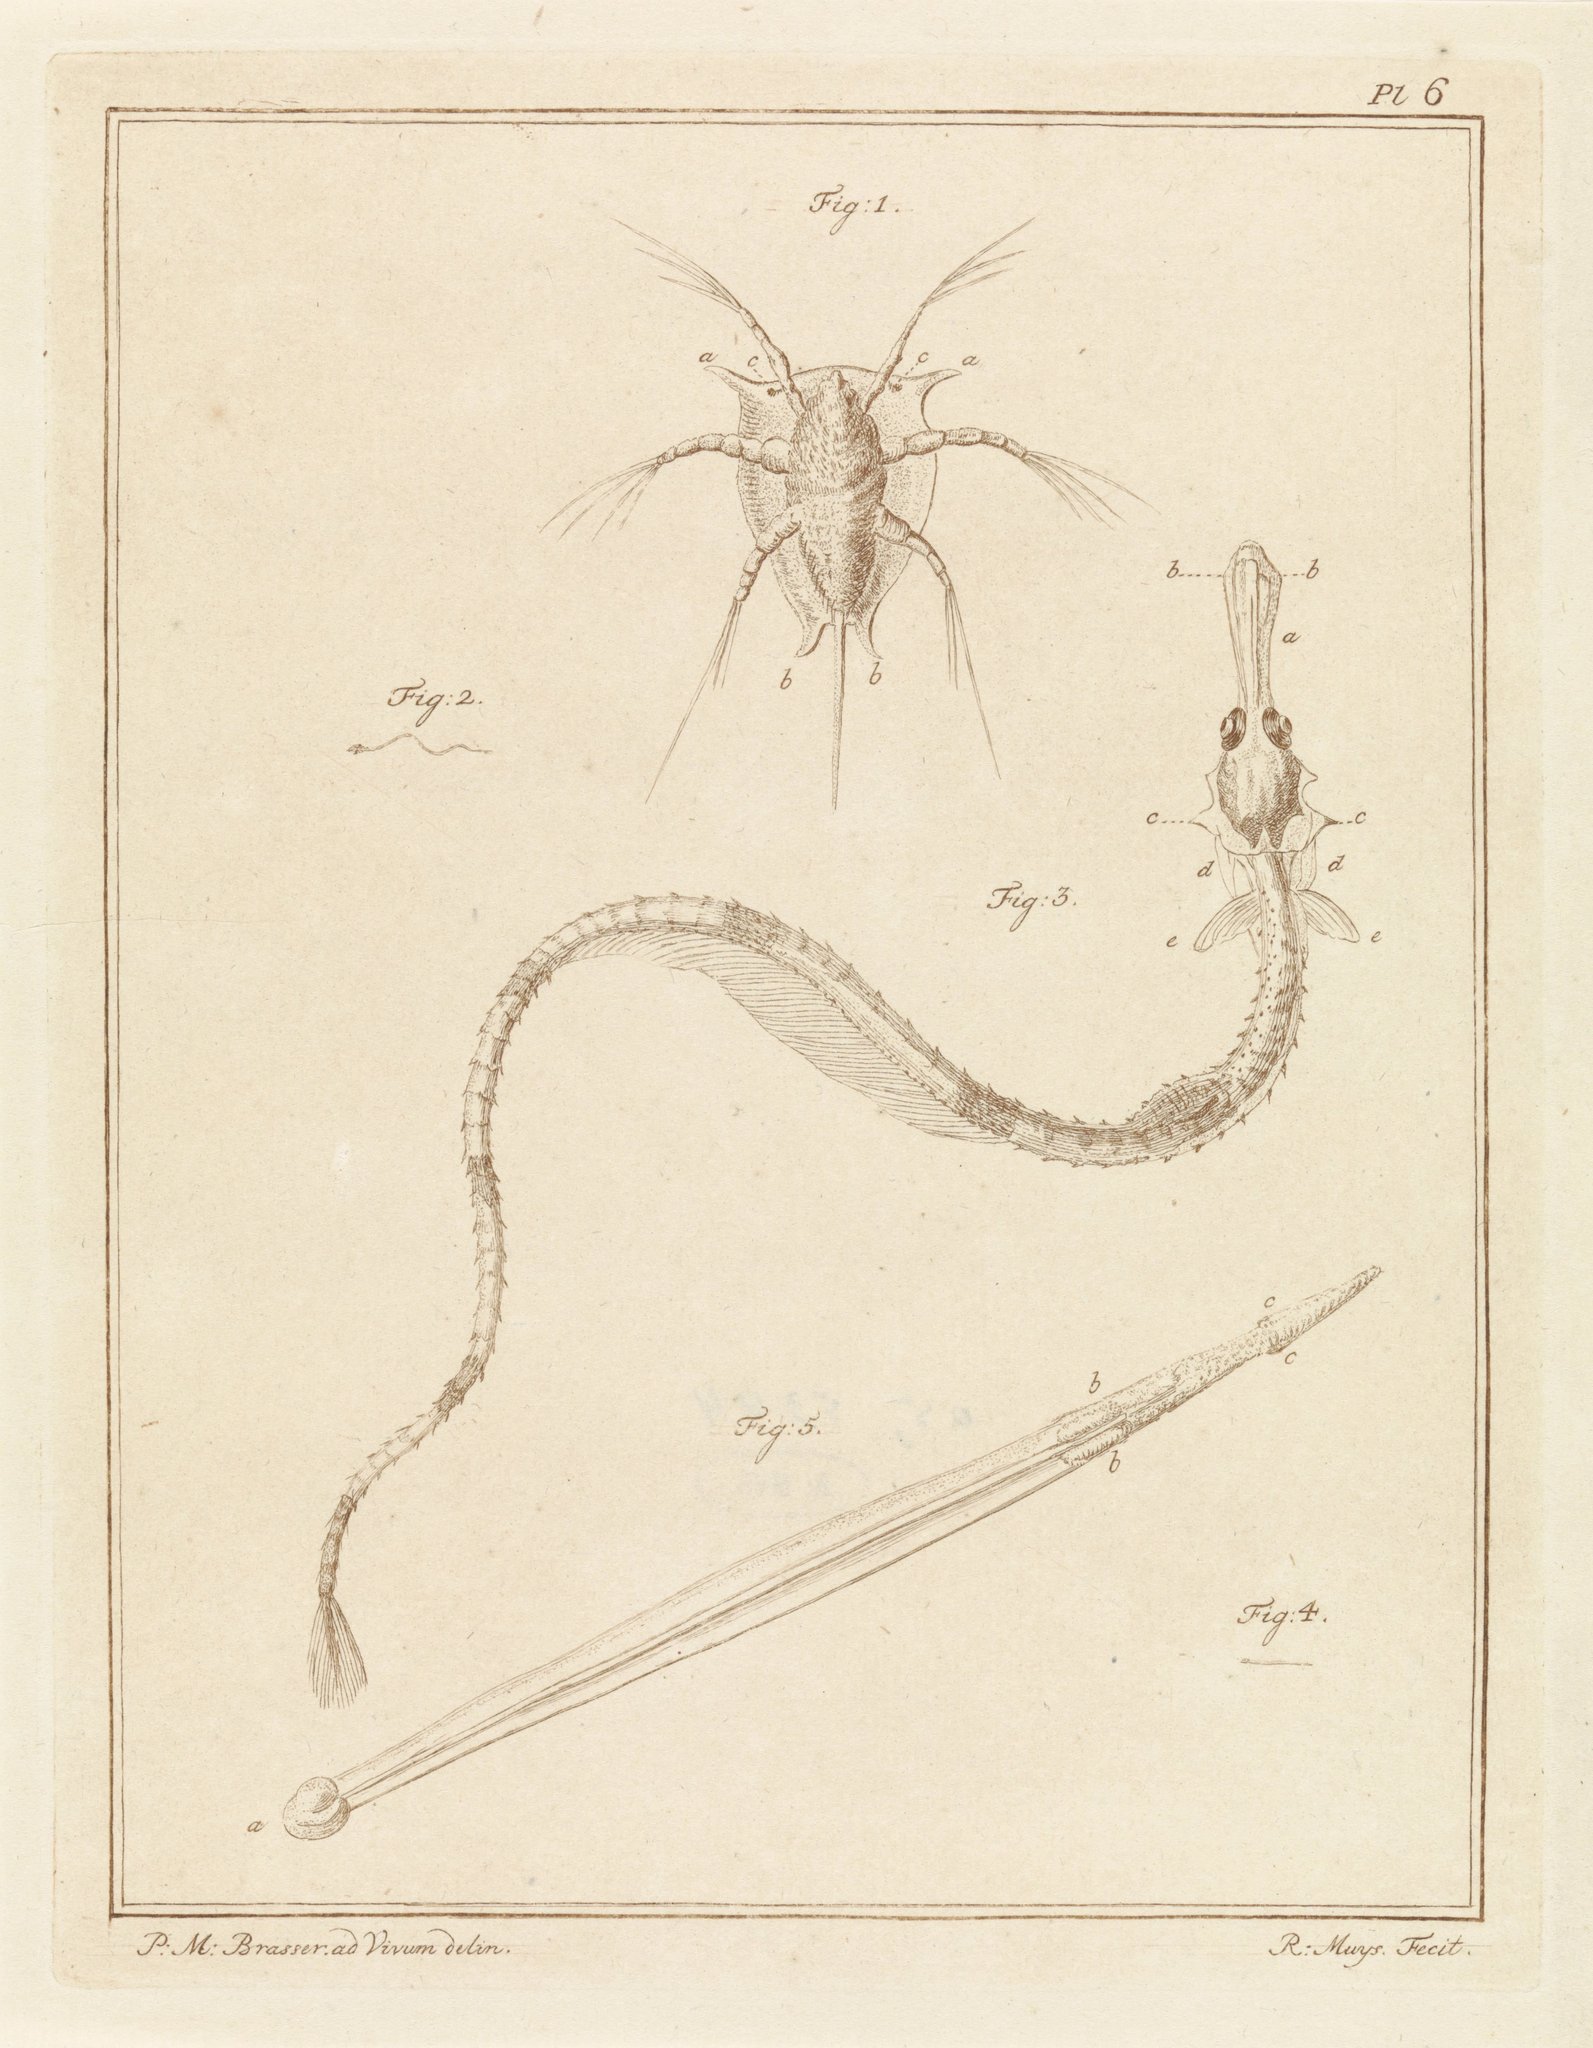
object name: book illustration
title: Gewone zeepok, grote zeenaald en een pijlwormsoort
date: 1778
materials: paper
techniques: etching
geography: rotterdam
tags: lower animals (+ animals ~ biological investigation)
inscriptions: collector's mark: Lugt 2228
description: Figuur 1 toont de gewone zeepok. Figuur 2 en 3 tonen de grote zeenaald op ware grootte en uitvergroot. Figuur 4 en 5 tonen een pijlwormsoort. Rechtsboven: Pl. 6. Prent uit een boek over binnen- en buitenlandse land- en waterdieren.